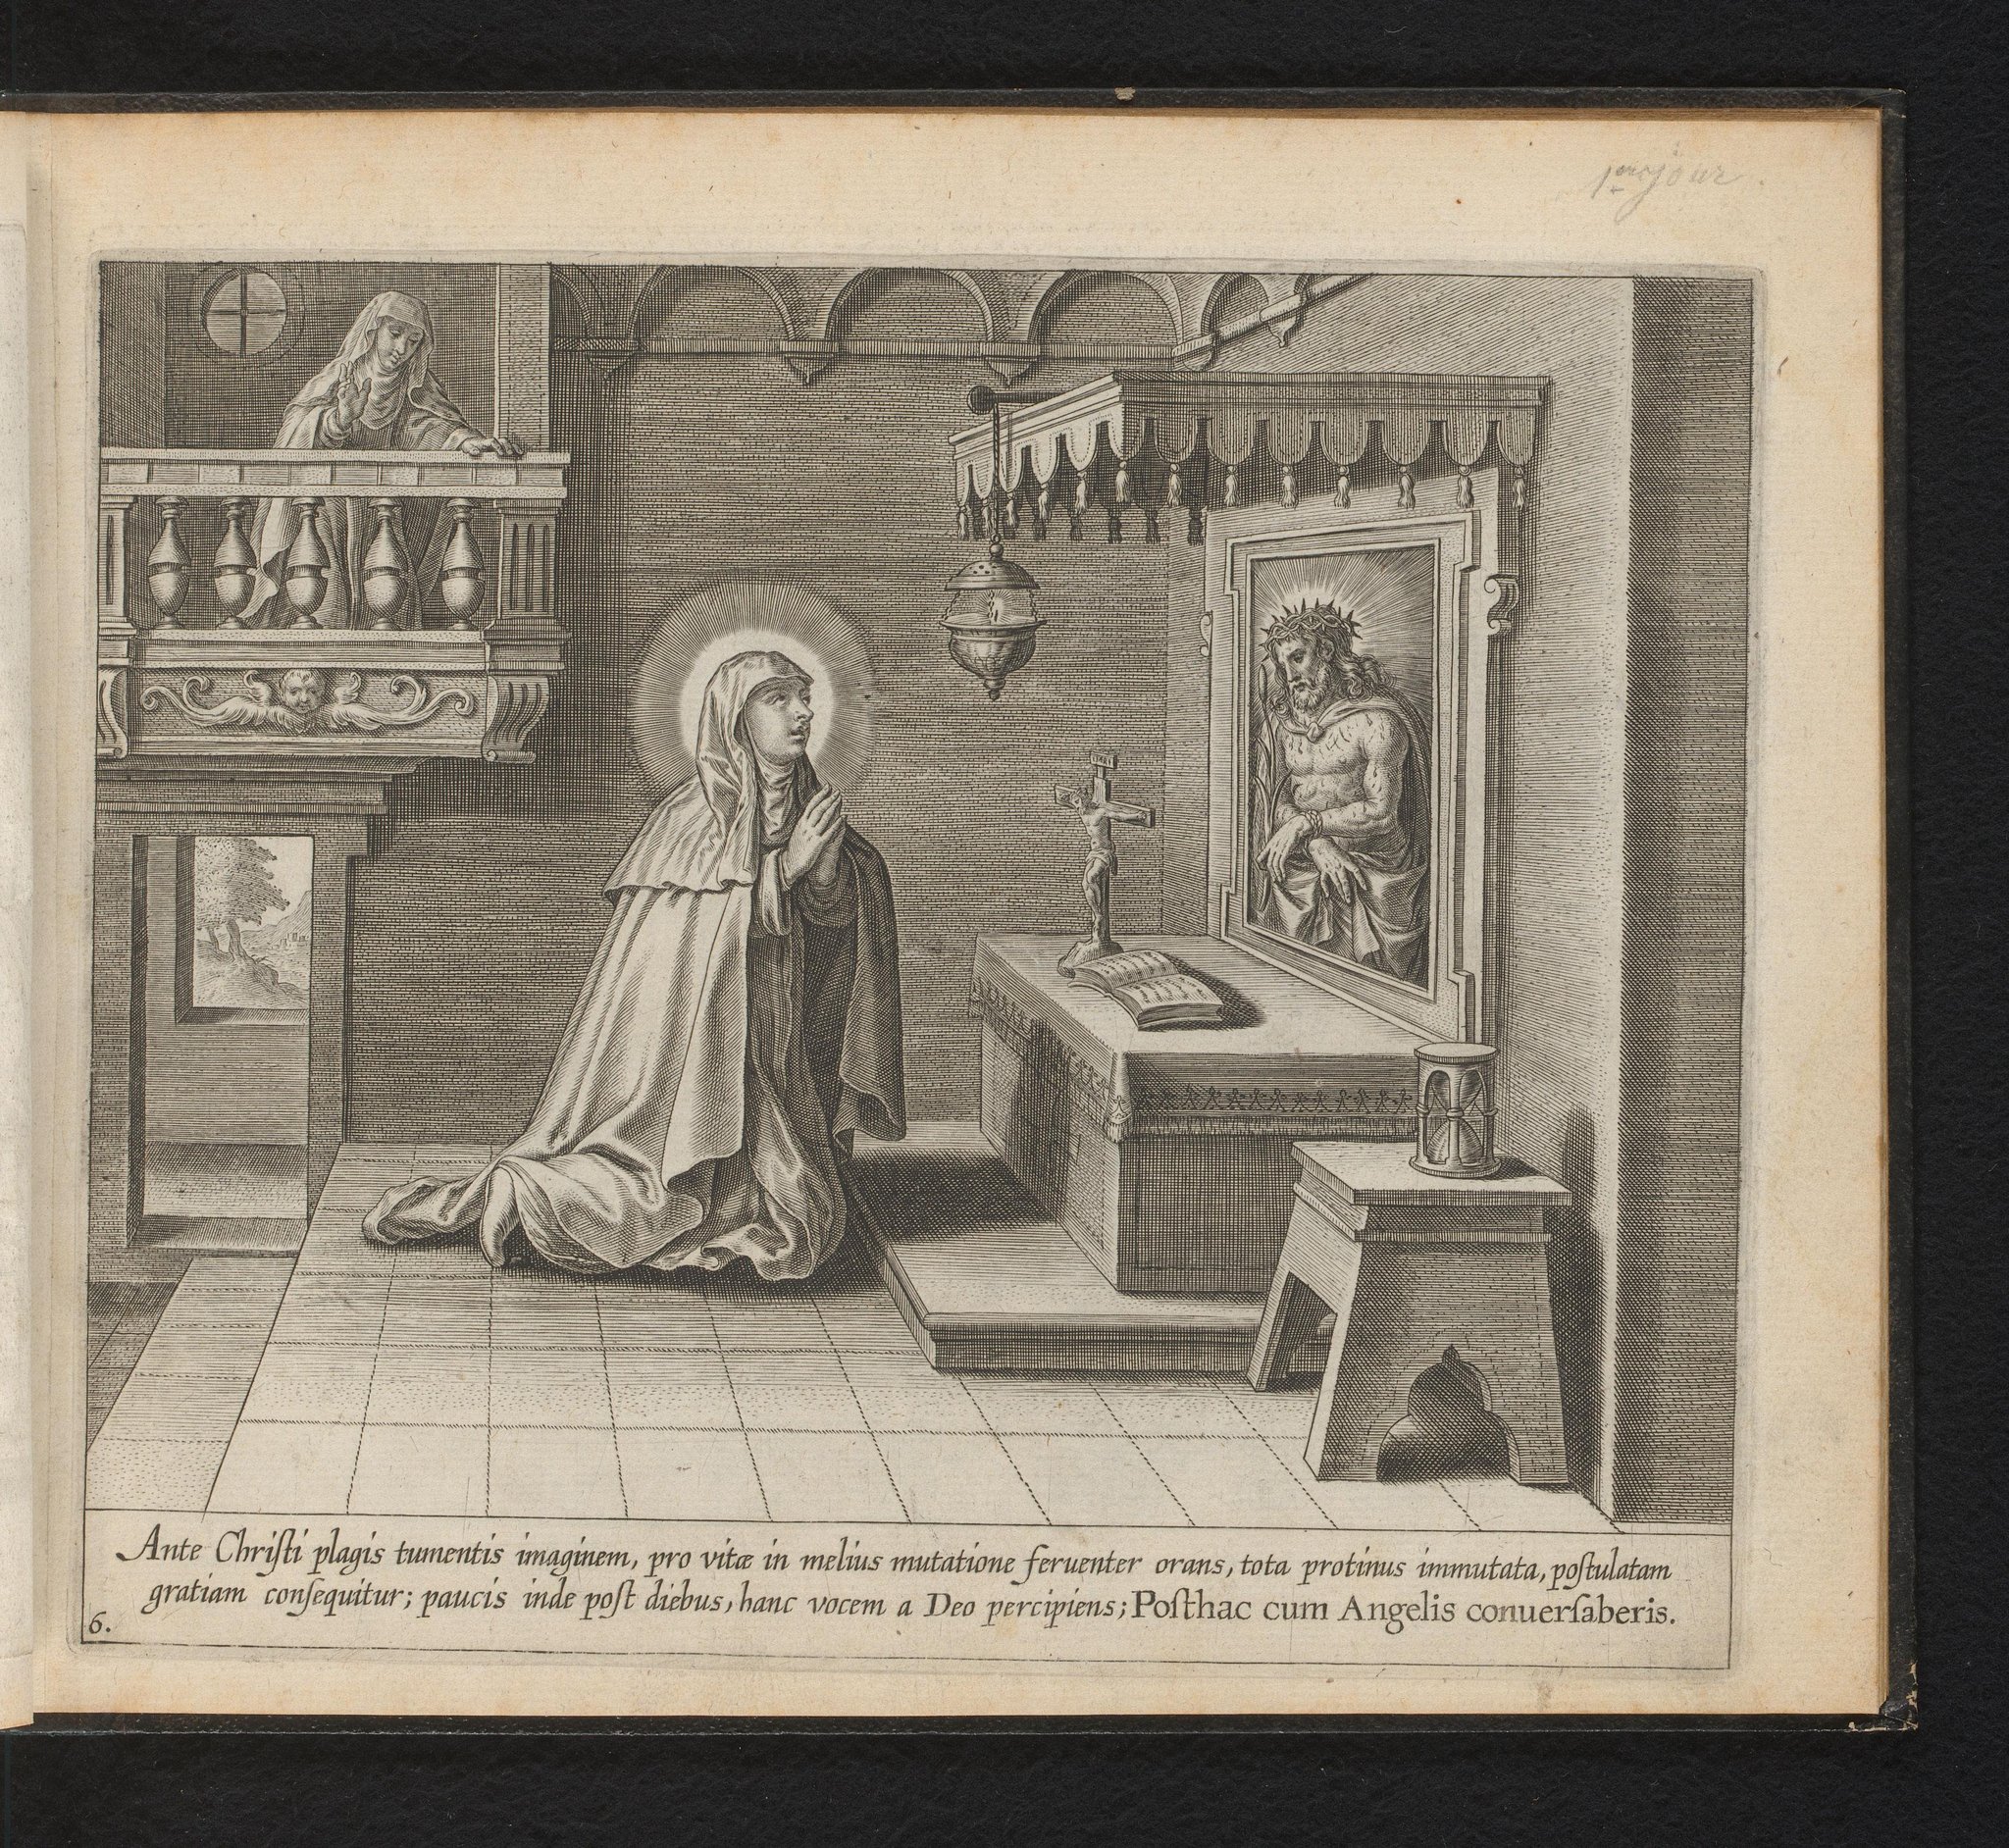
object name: print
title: De H. Teresa in vurig gebed voor een afbeelding van Christus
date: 1613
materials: paper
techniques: engraving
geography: antwerp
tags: the foundress of the reformed (discalced) carmelites, t(h)eres(i)a of avila; possible attributes: angel, arrow, dove, heart (flaming or pierced by an arrow)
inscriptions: caption: ‘Ante Christi plagis...cum Angelis conversaberis.’, number: ‘6’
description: De H. Teresa in vurig gebed voor een afbeelding van Christus. Zij hoort Gods stem en praat ze met de engelen. Prent in album 'Vita B. Virginis Teresiae A. Jesu ordinis carmelitarum excalceatorum piae restauratricis..., 1613.